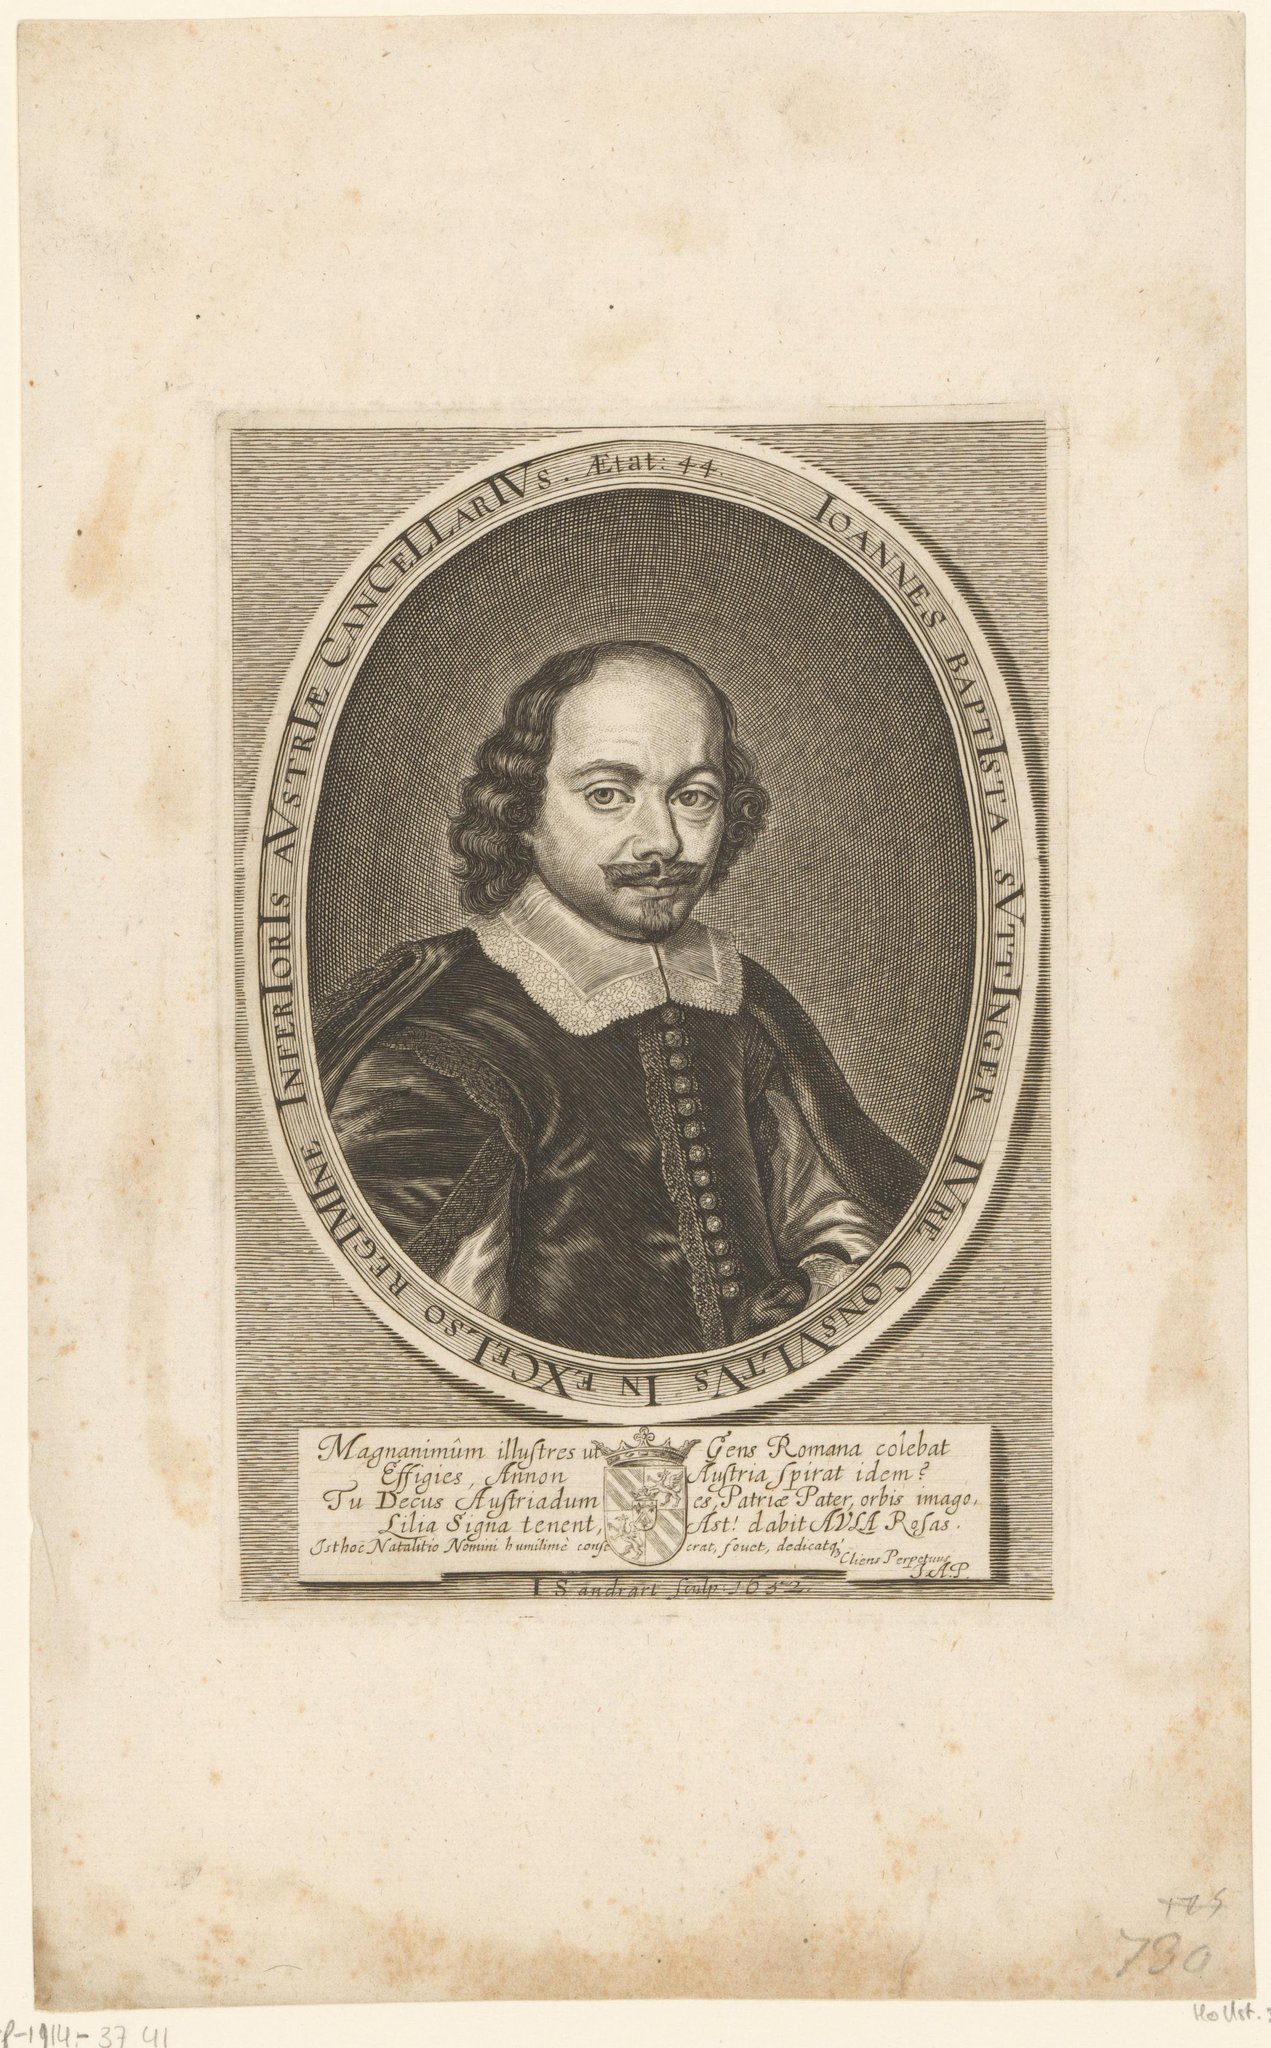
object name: print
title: Portret van Johann Baptist, Ritter von Suttinger zum Thurnhoff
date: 1652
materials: paper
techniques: engraving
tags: vienna, historical persons, armorial bearing, heraldry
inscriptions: collector's mark: Lugt 2228